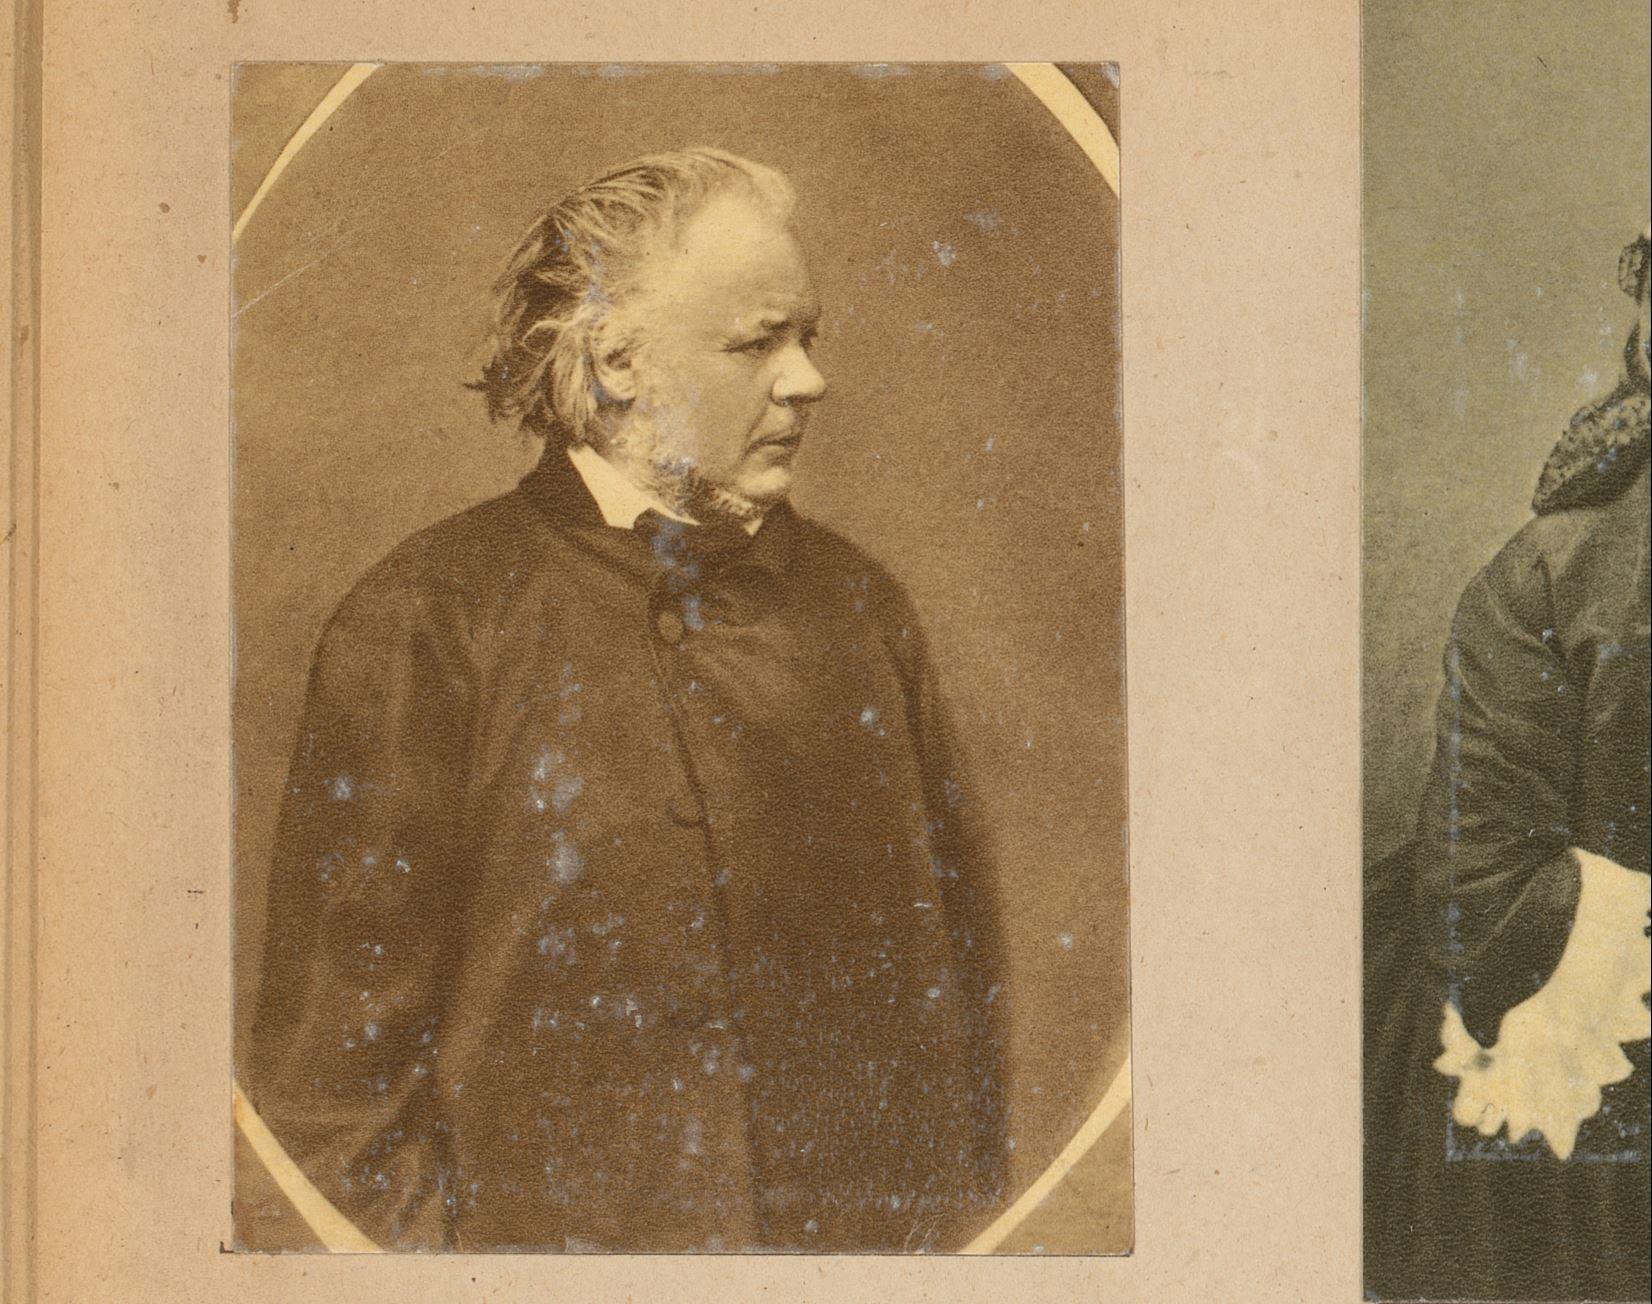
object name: album leaf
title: Portret van Honoré Daumier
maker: Anonymous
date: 1868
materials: paper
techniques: rotogravure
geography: france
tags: marseille, painter, print maker, draughtsman, honoré daumier, historical persons, artist (in general), france